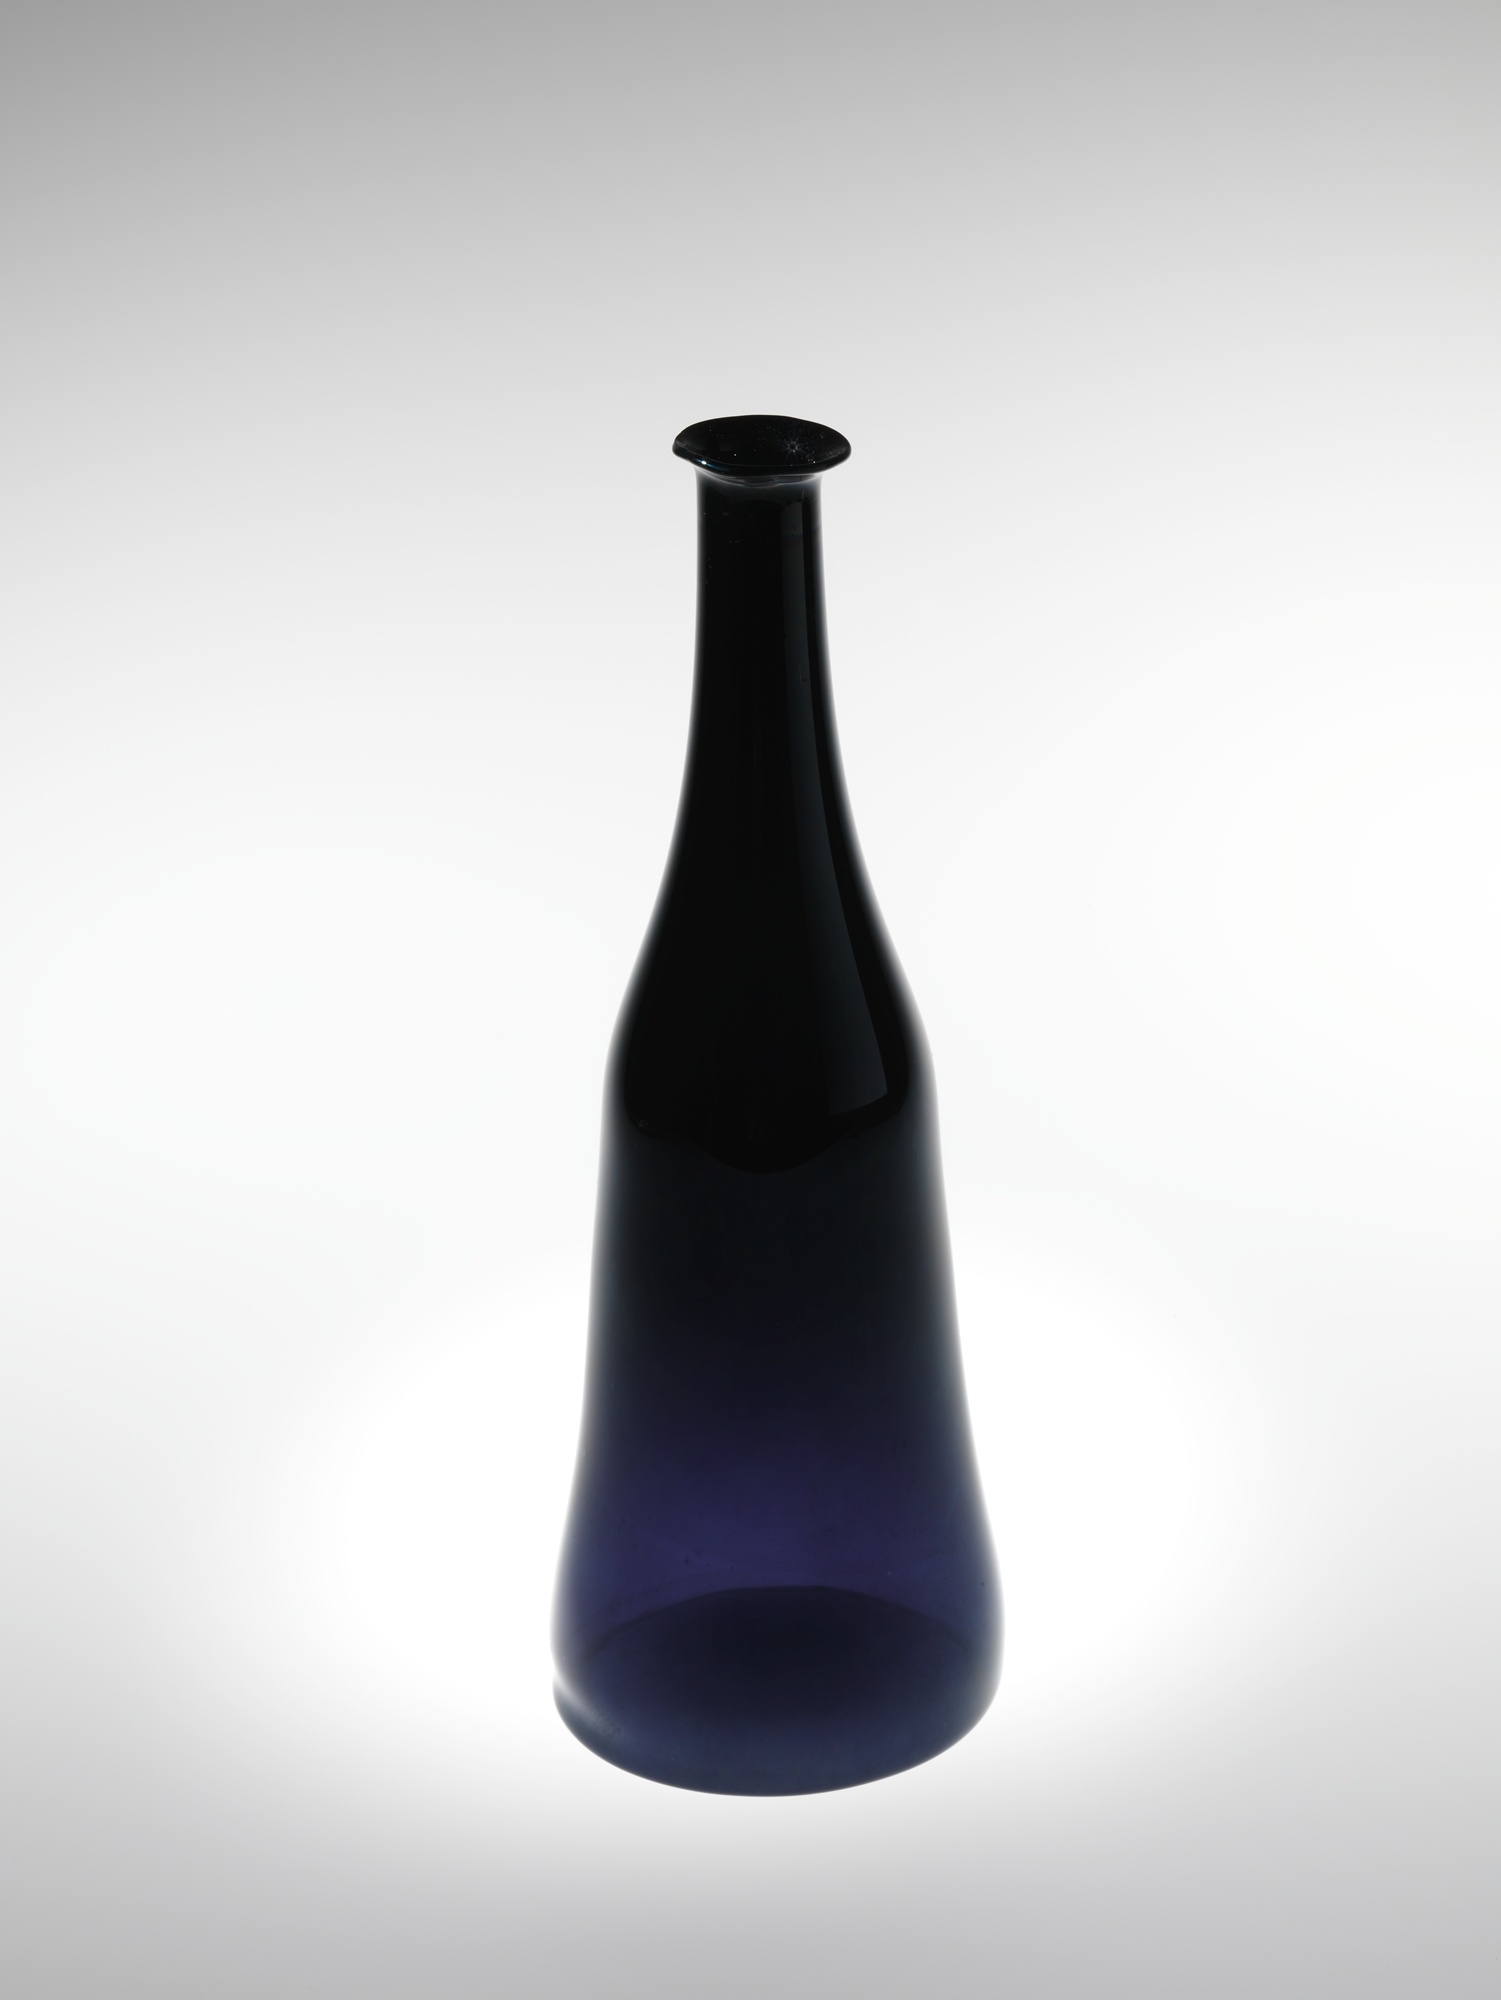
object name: wine bottle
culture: japanese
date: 1801-1900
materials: glass